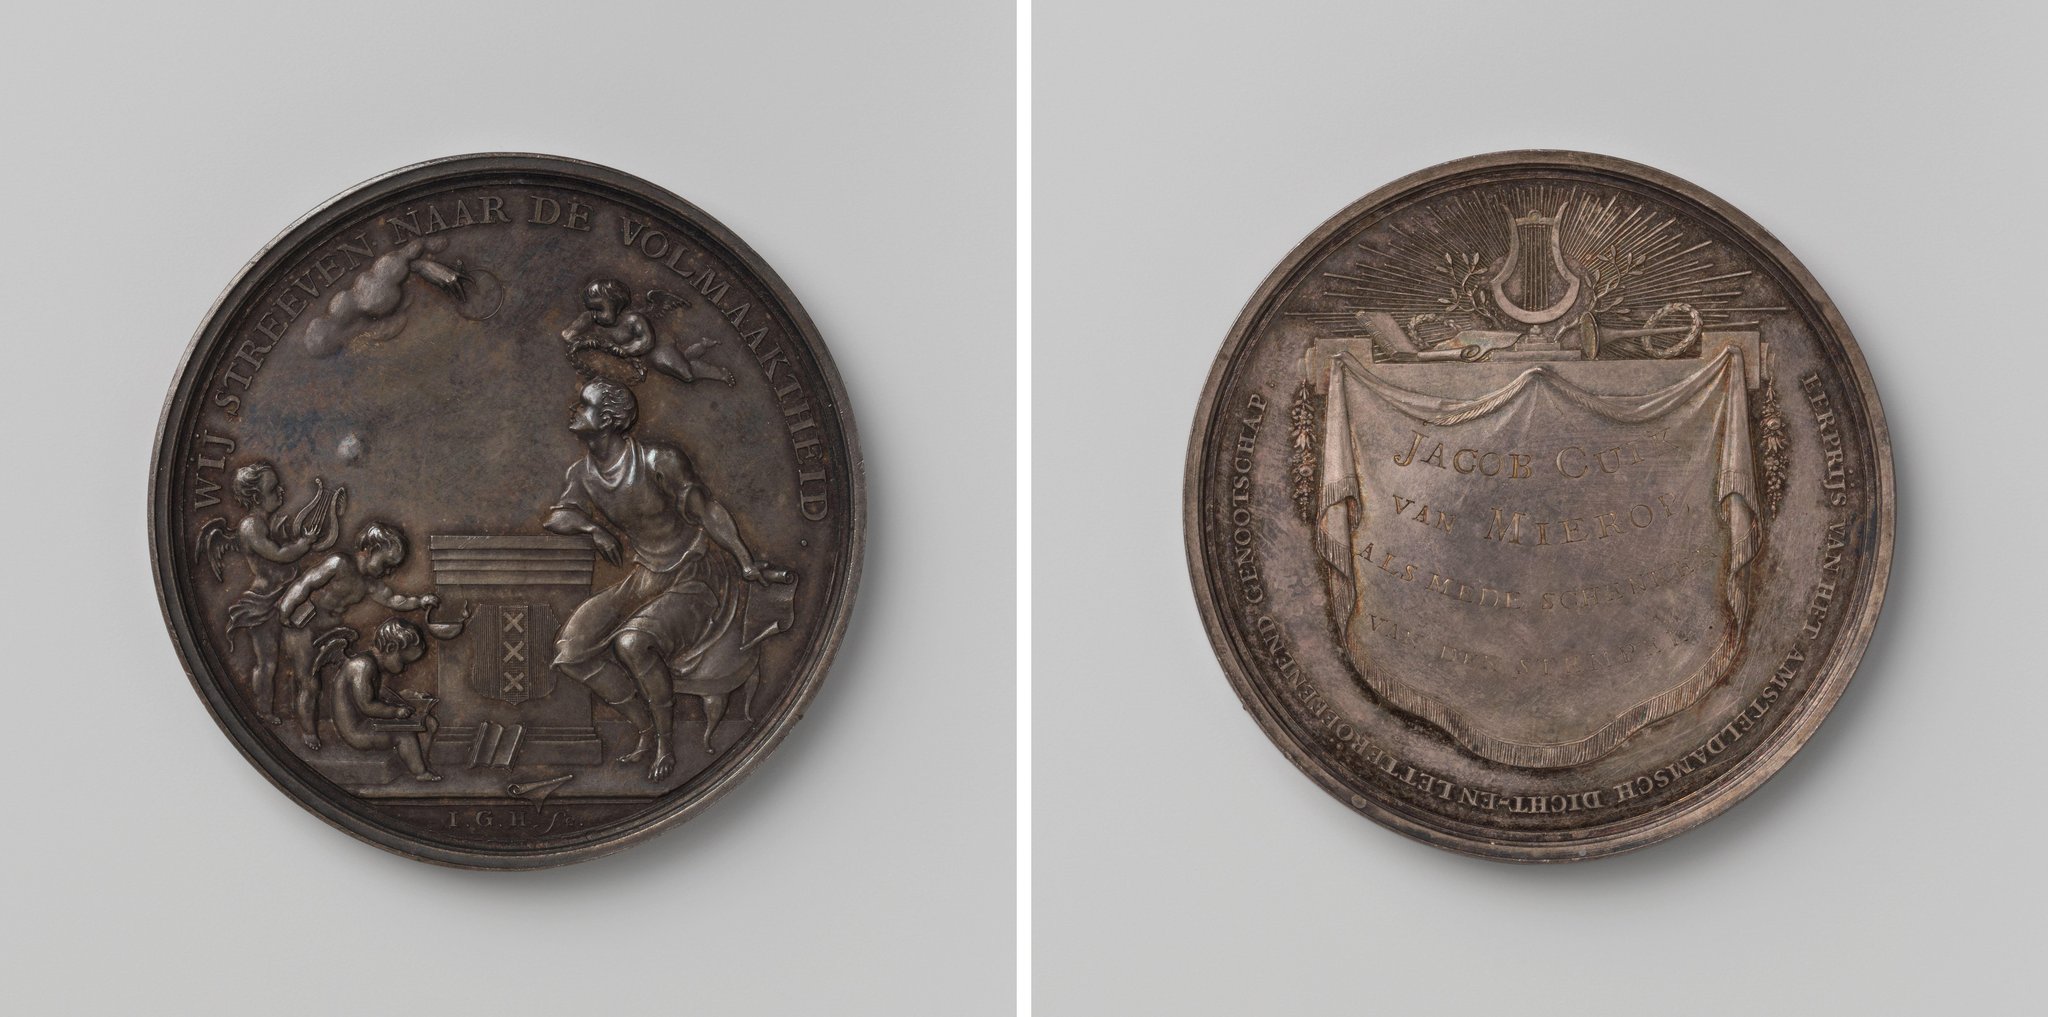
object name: medal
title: Amsteldamsch Dicht- en Letteroefenend Genootschap "Wij streeven naar de volmaaktheid", penning uitgereikt aan Jacob Cuyck van Mierop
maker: johan george holtzhey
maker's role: mintmaster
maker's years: 1726-1808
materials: silver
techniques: engraving, striking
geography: amsterdam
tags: amsterdam